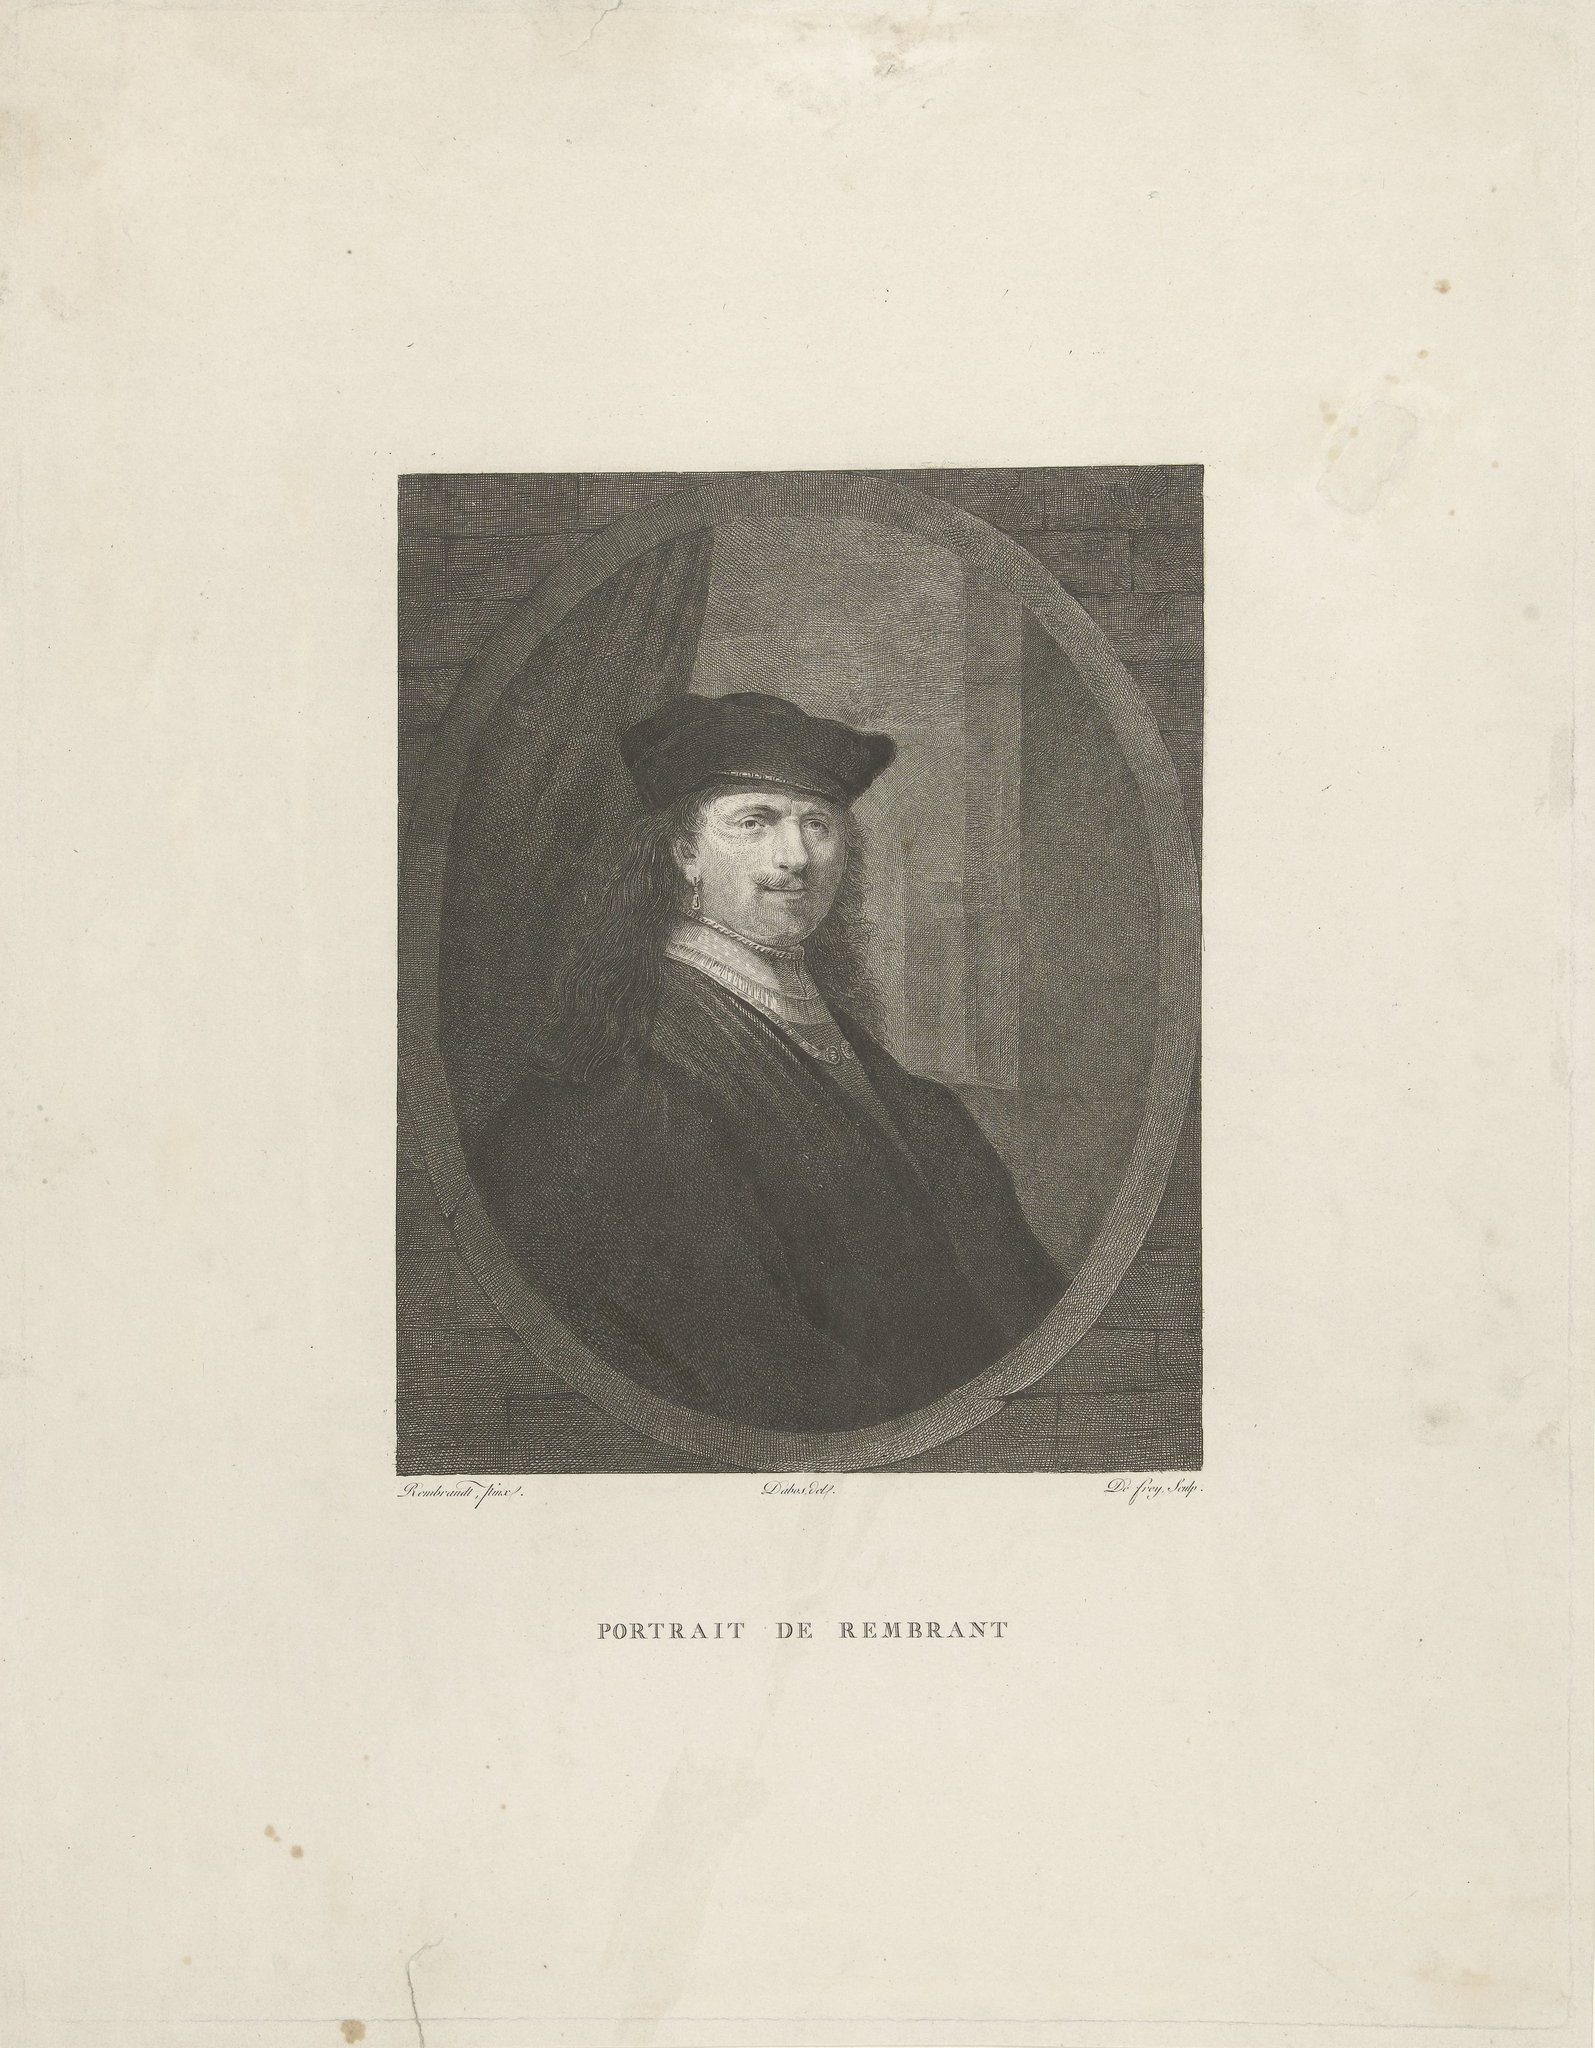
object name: print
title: Portrait de Rembrant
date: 1780-1834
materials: paper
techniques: etching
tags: leiden, amsterdam, painter, print maker, draughtsman, rembrandt van rijn, portrait, self-portrait of artist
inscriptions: collector's mark: Lugt 2228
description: Portret in ovaal van Rembrandt van Rijn. Ten halven lijve, naar rechts. Rembrandt is gehuld in een mantel en draagt een hoofddeksel.